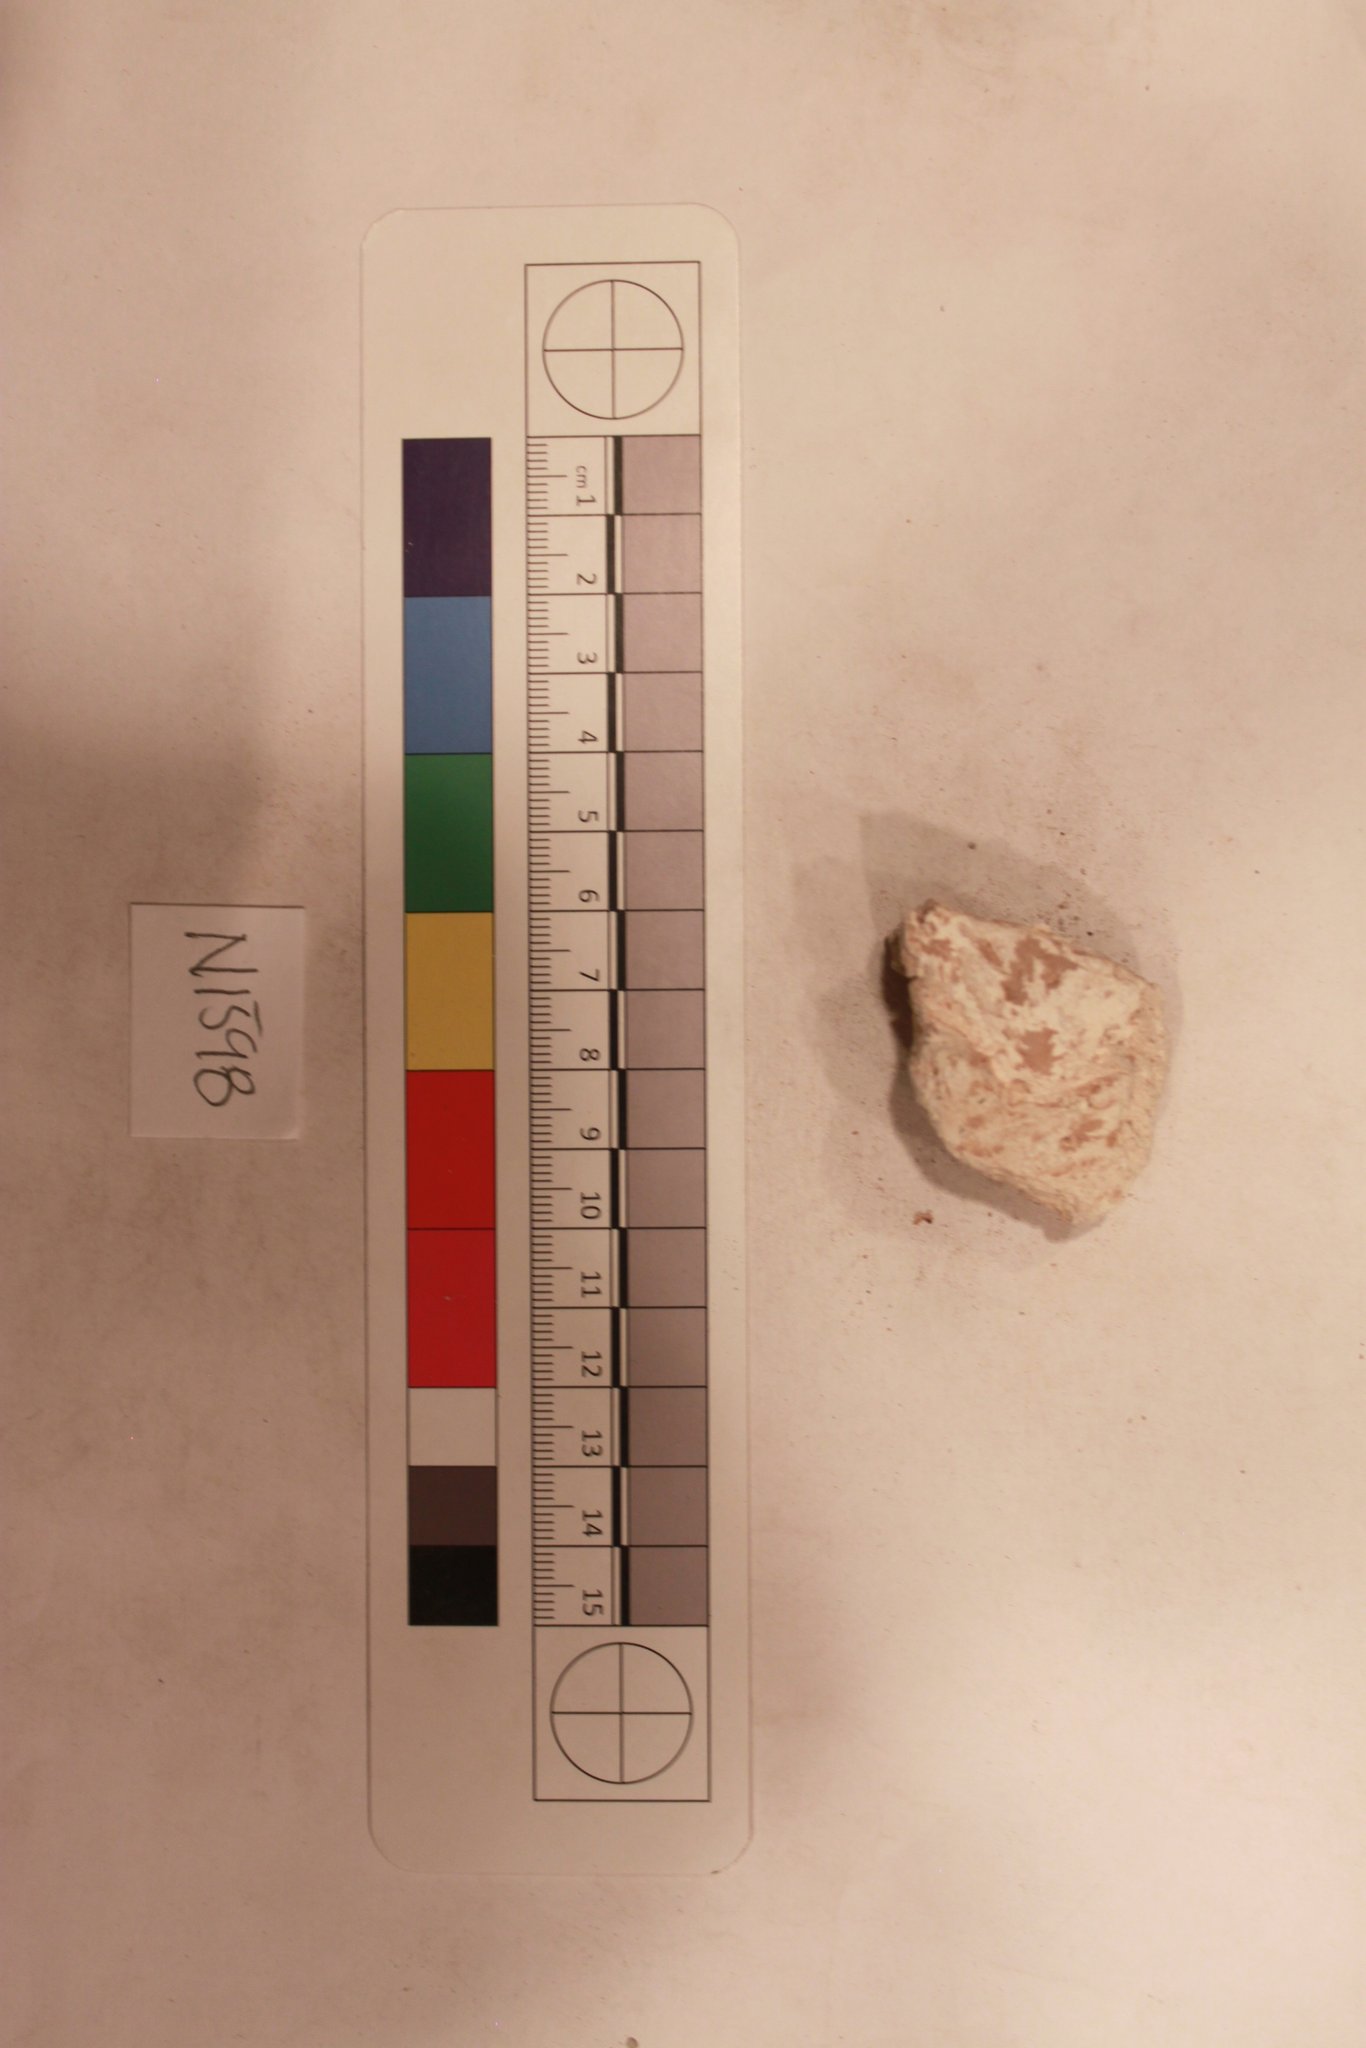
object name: fragment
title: Stucco Fragment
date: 701-1200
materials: plaster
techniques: carving, painting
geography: iran